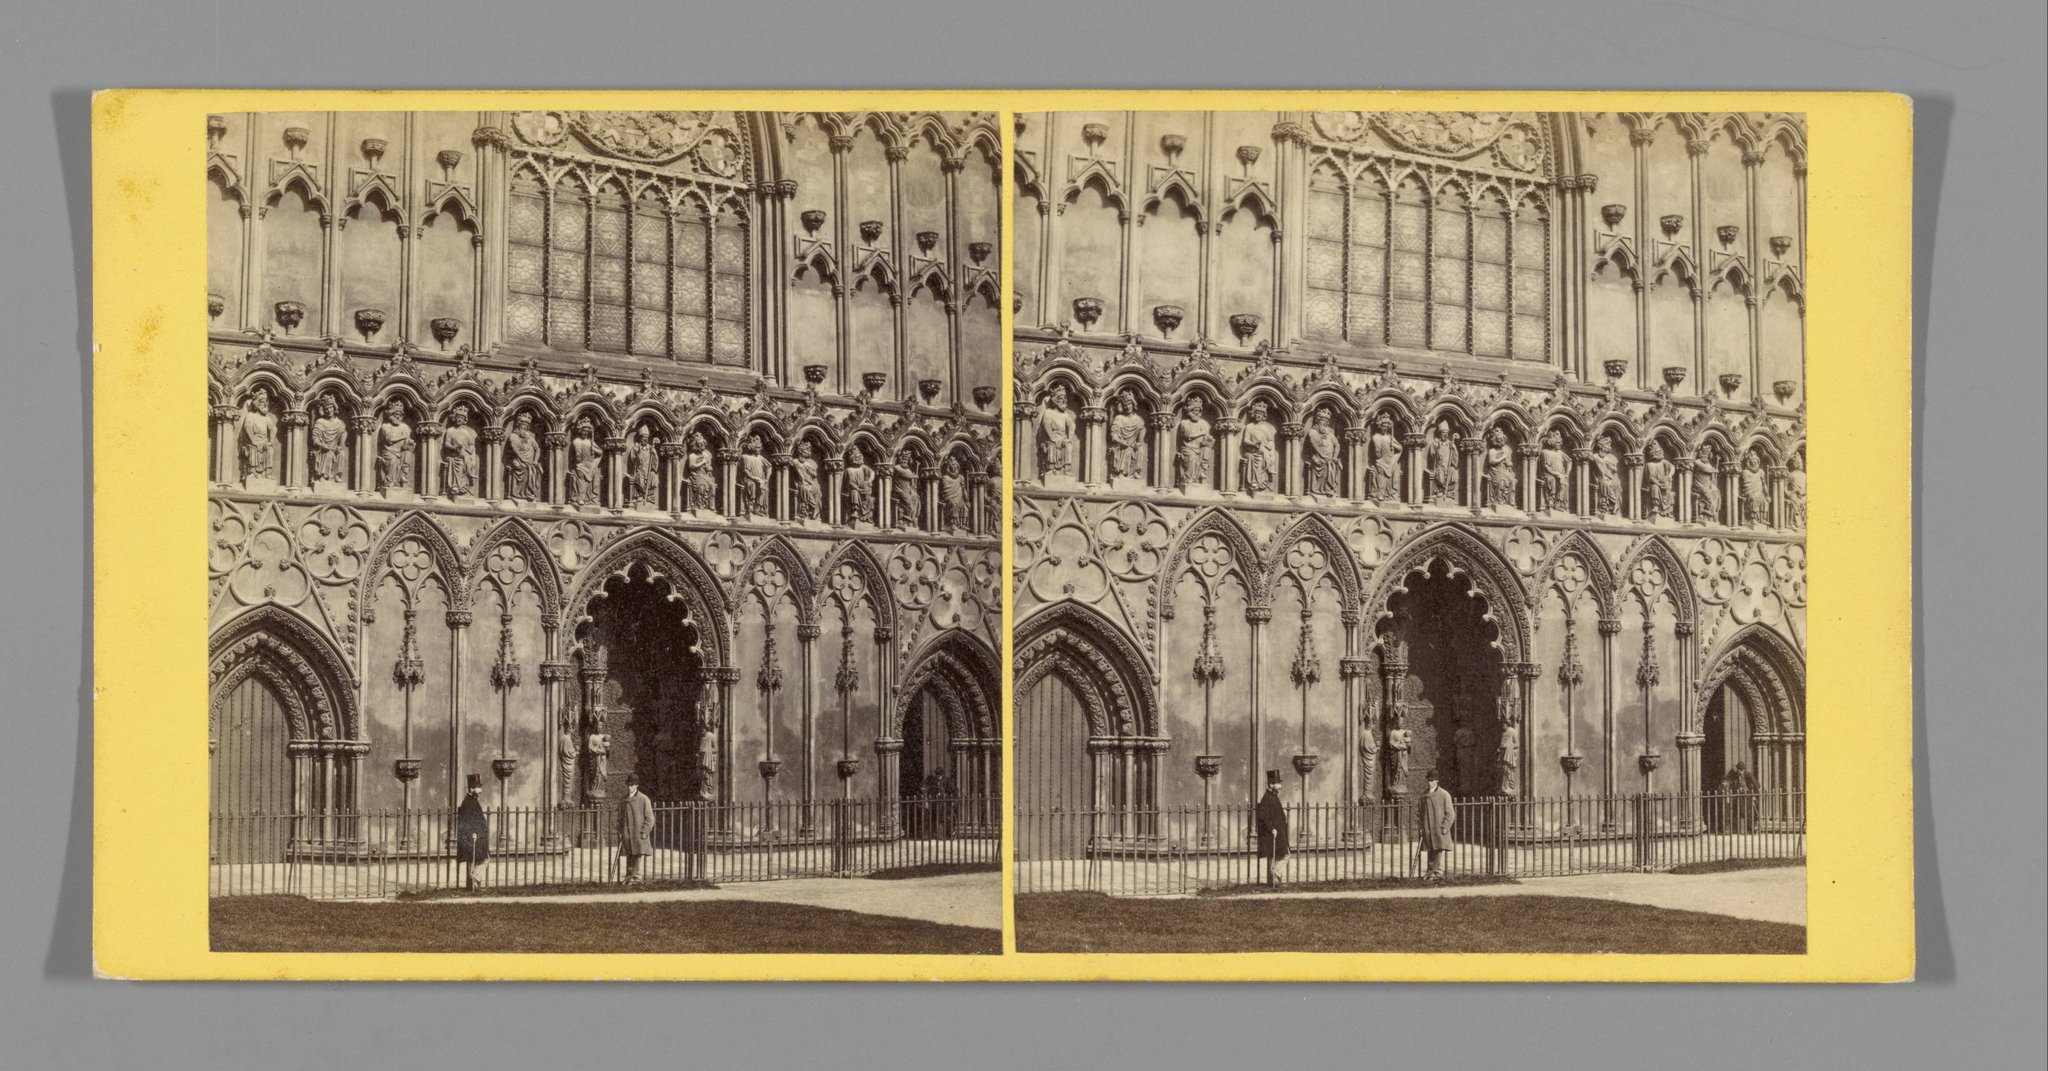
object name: stereograph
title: Lichfield Cathedral: The West Front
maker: alexander wilson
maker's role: fotograaf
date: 1850-1880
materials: cardboard, photographic support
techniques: albumen print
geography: lichfield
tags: church (exterior), façade (of house or building)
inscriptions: name: ‘Alexander Wilson, Photographer, Leamington.’, number: ‘No. 101.’